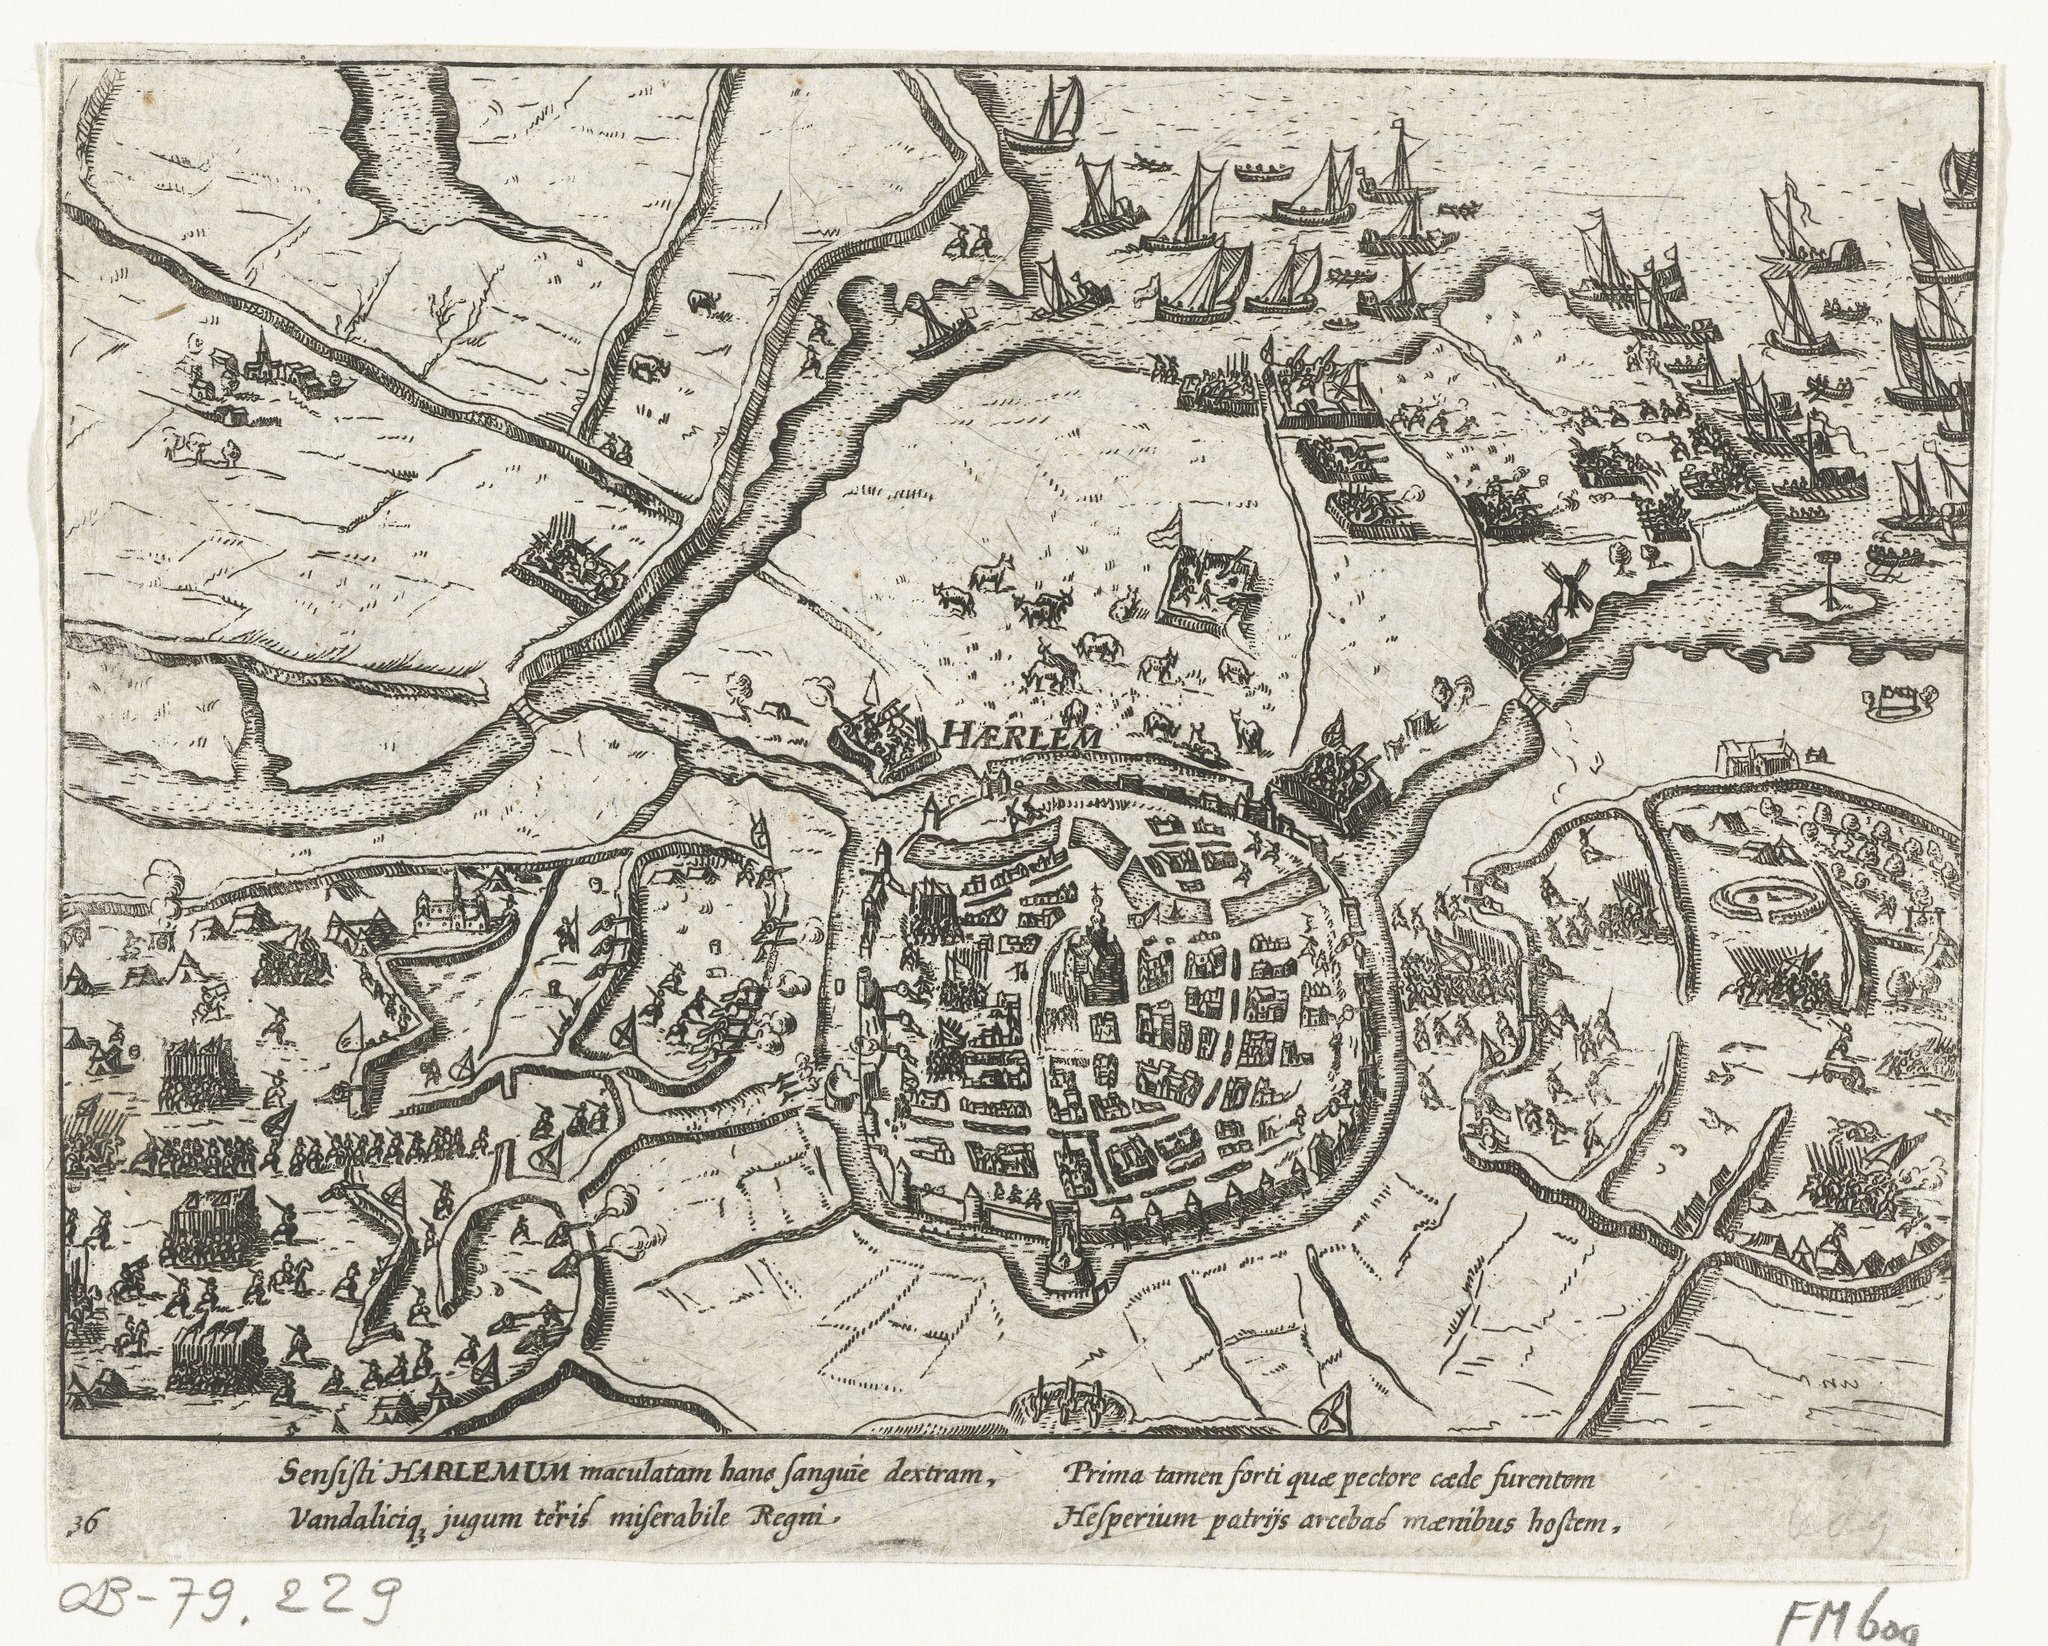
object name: print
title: Beleg van Haarlem, 1572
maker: Anonymous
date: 1613-1615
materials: paper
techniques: etching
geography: germany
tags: maps of separate countries or regions, siege, position war, maps of cities, haarlem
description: Kaart van de stad Haarlem en het omringend gebied met de legerplaatsen van de belegerende Spaanse troepen van Don Frederik. Boven schepen van Alva en de prins van Oranje op het water van het Haarlemmermeer. Het beleg ving aan op 11 december 1572. Met onderschrift van 4 regels in het Latijn. Genummerd: 36. Bedrukt op achterzijde met tekst in het Latijn.